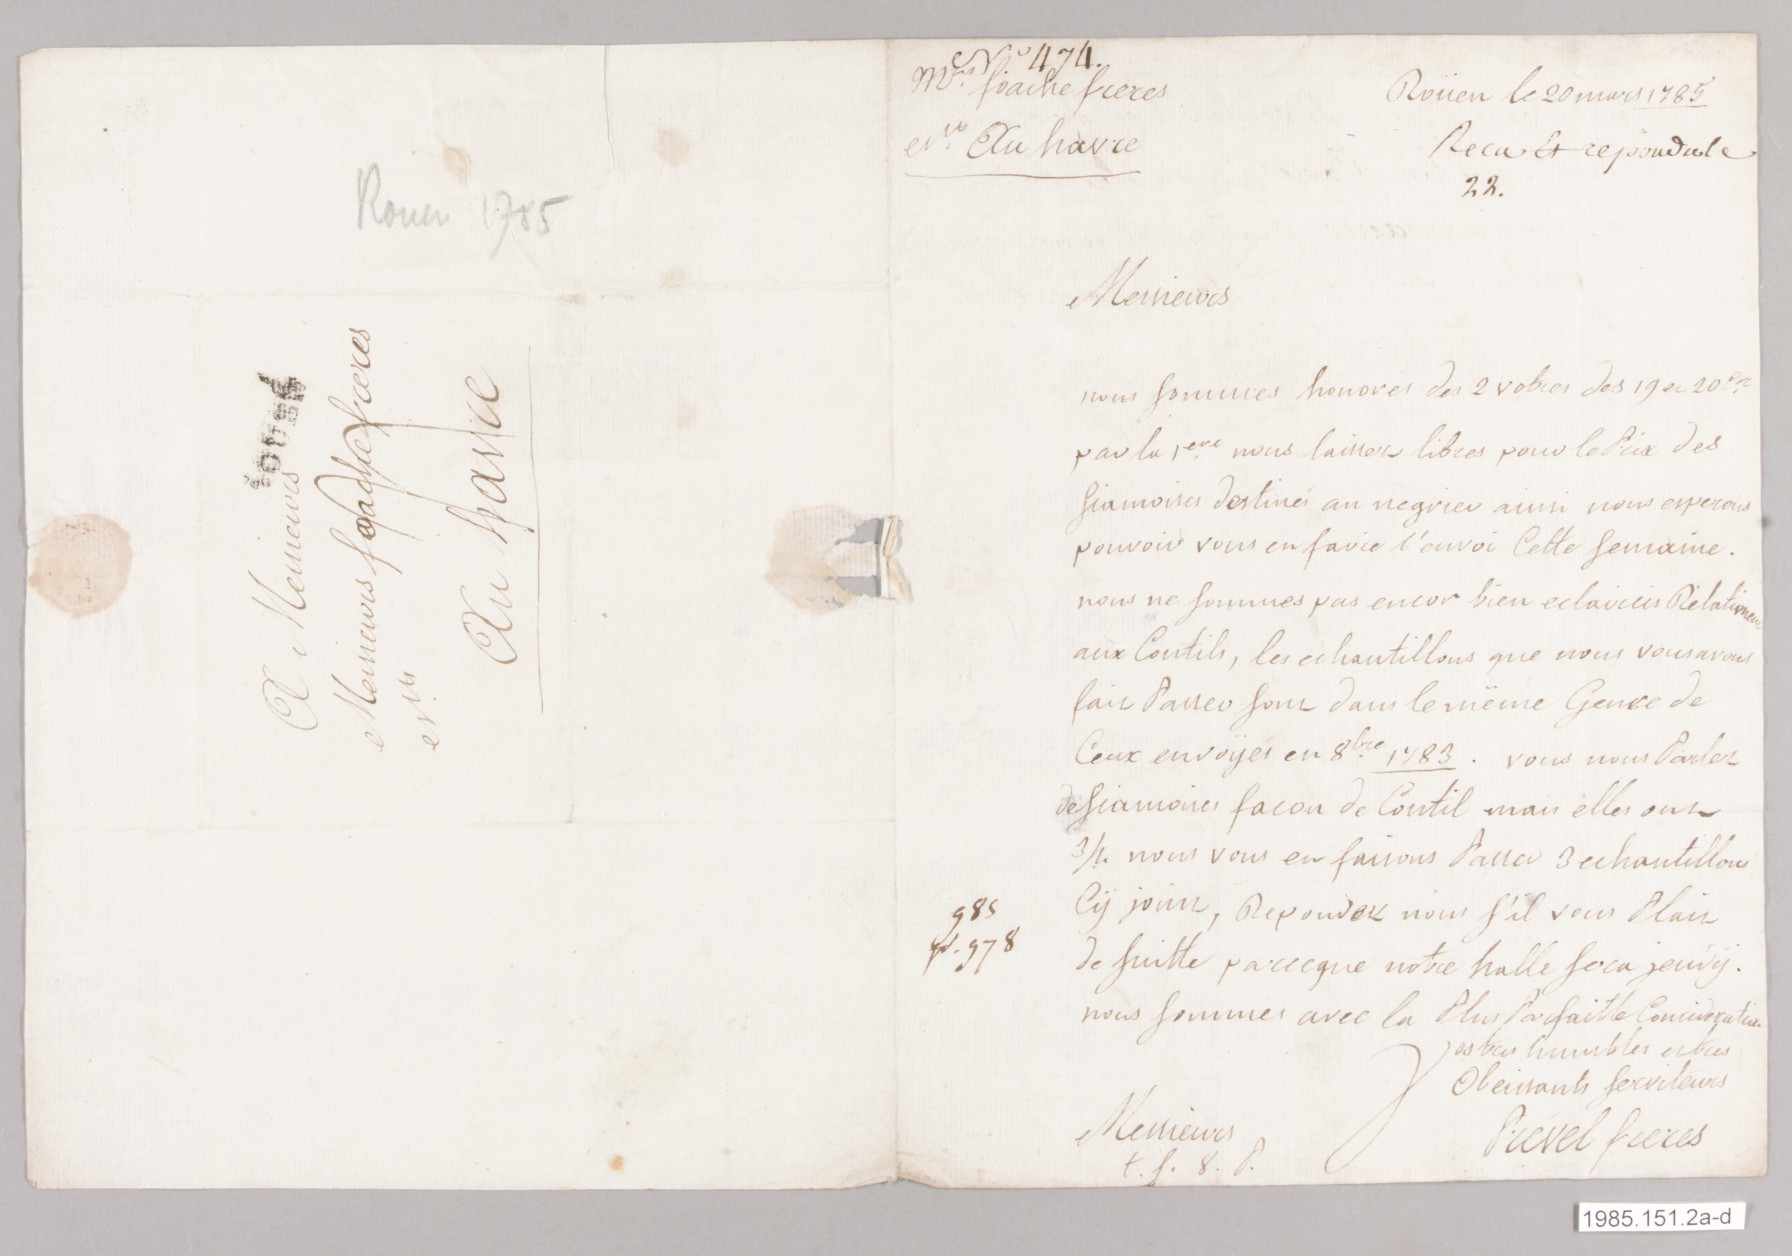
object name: sample and letter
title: Textile swatch to accompany letter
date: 1767-1800